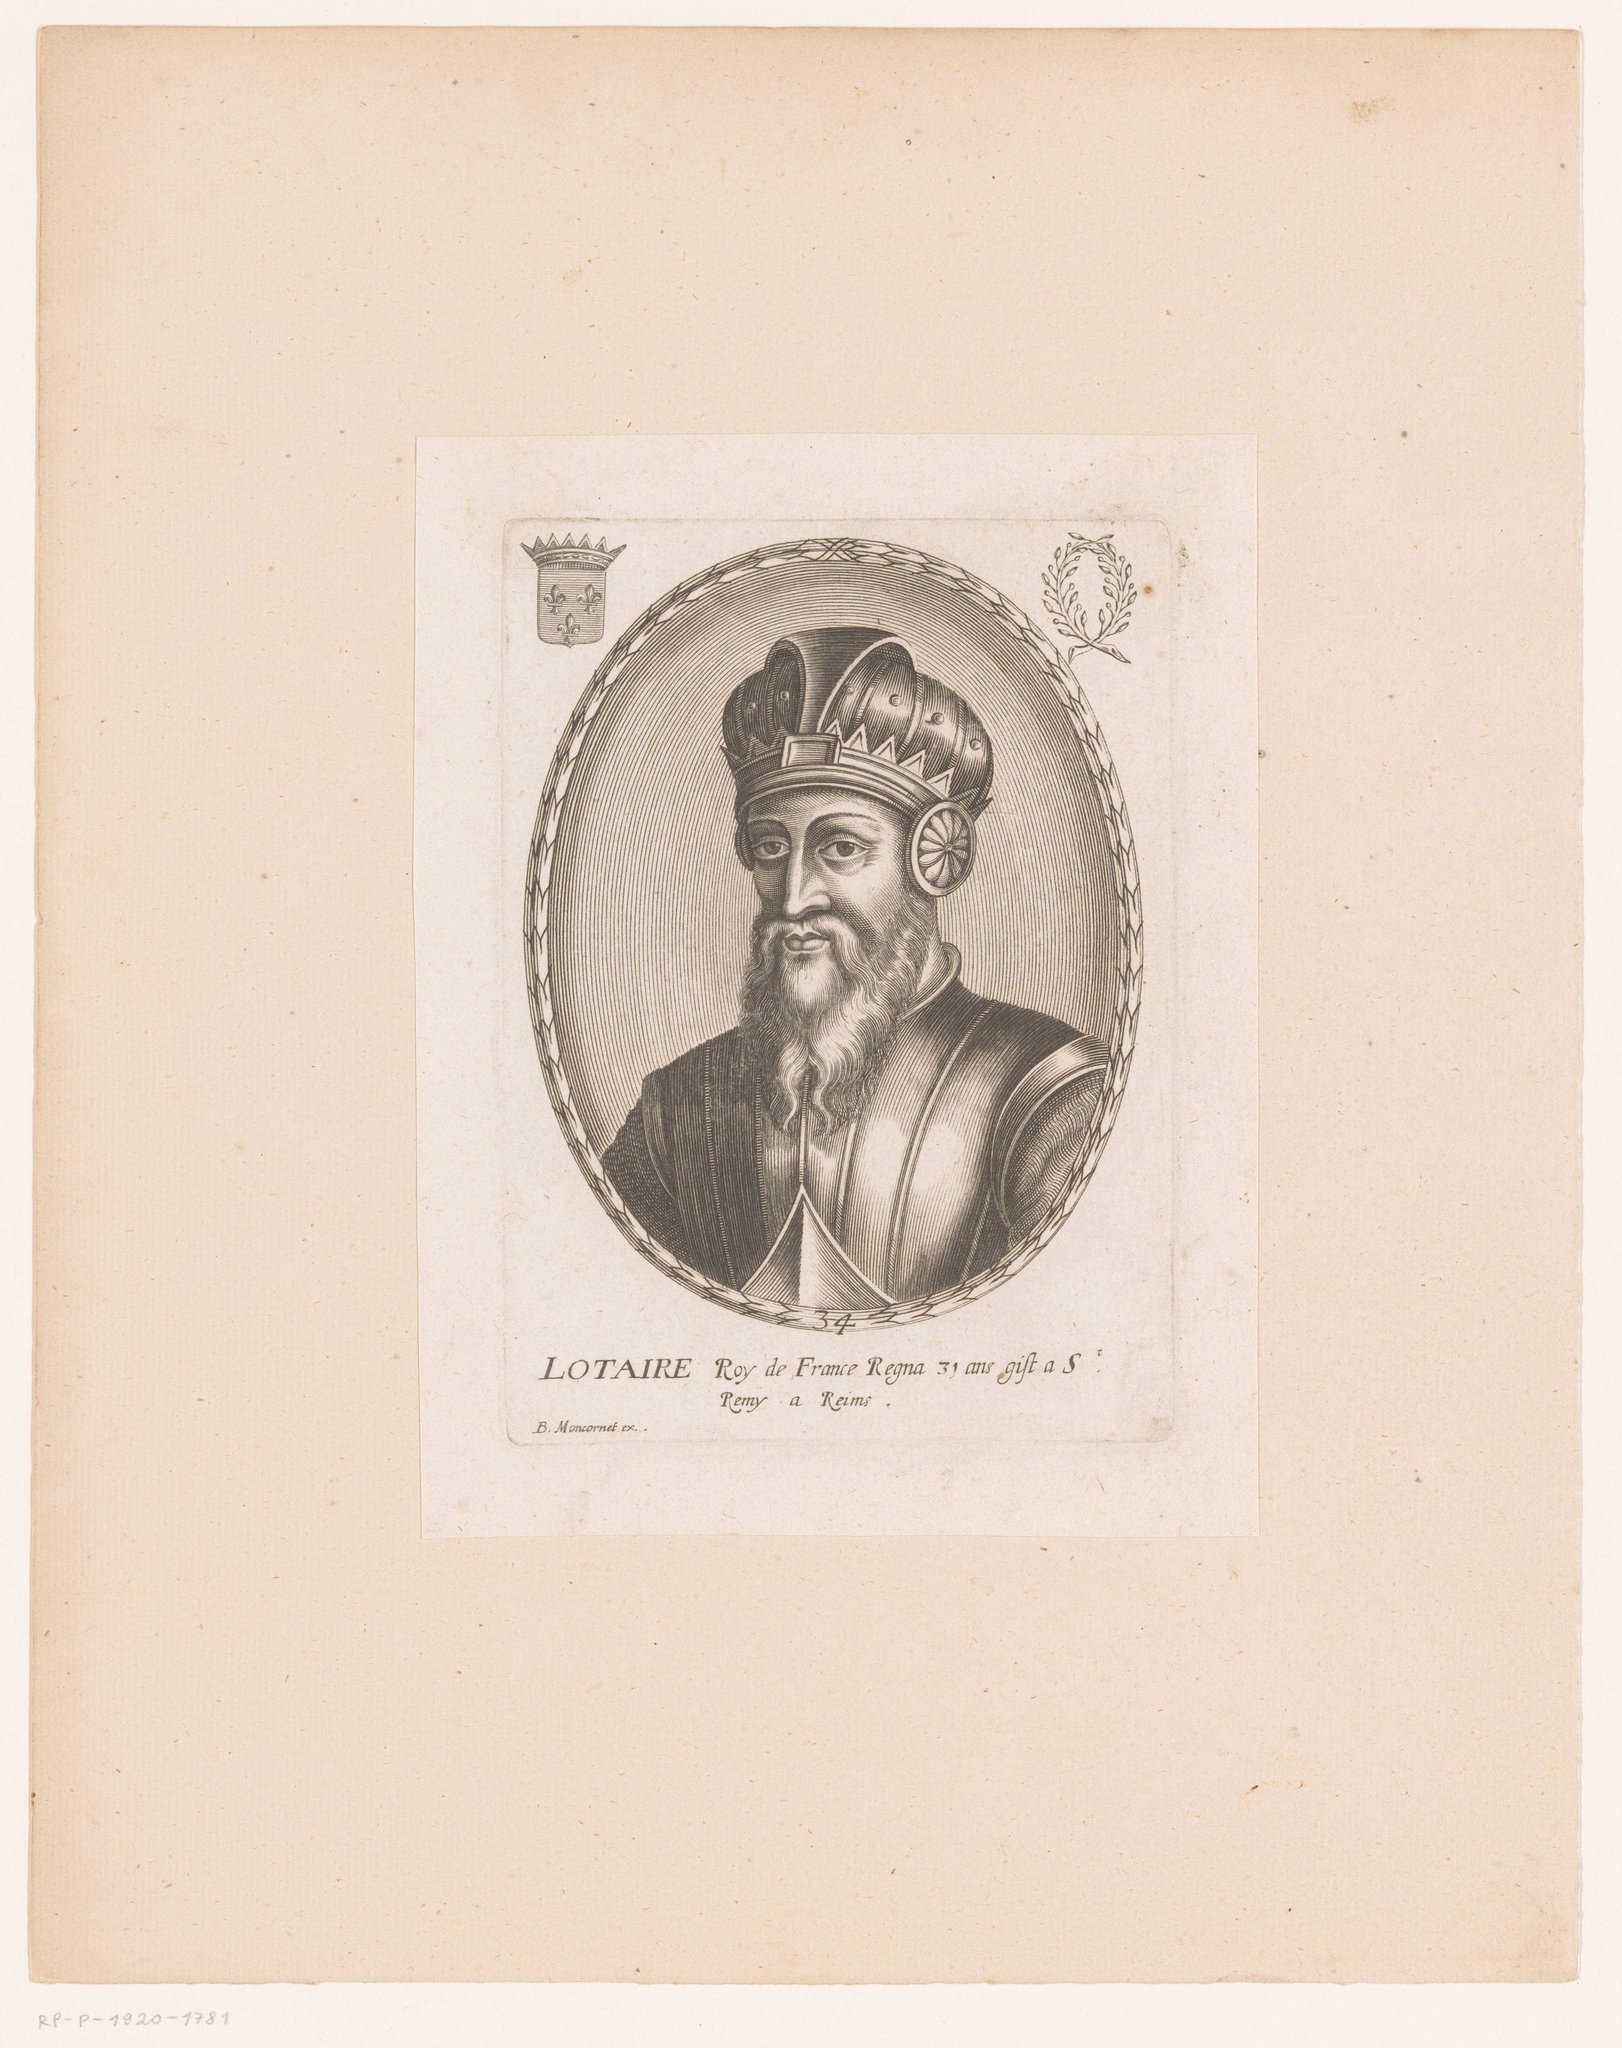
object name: print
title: Portret van Lotharius van Frankrijk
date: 1610-1668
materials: paper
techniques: engraving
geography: paris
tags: historical persons, king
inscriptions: collector's mark: Lugt 2228